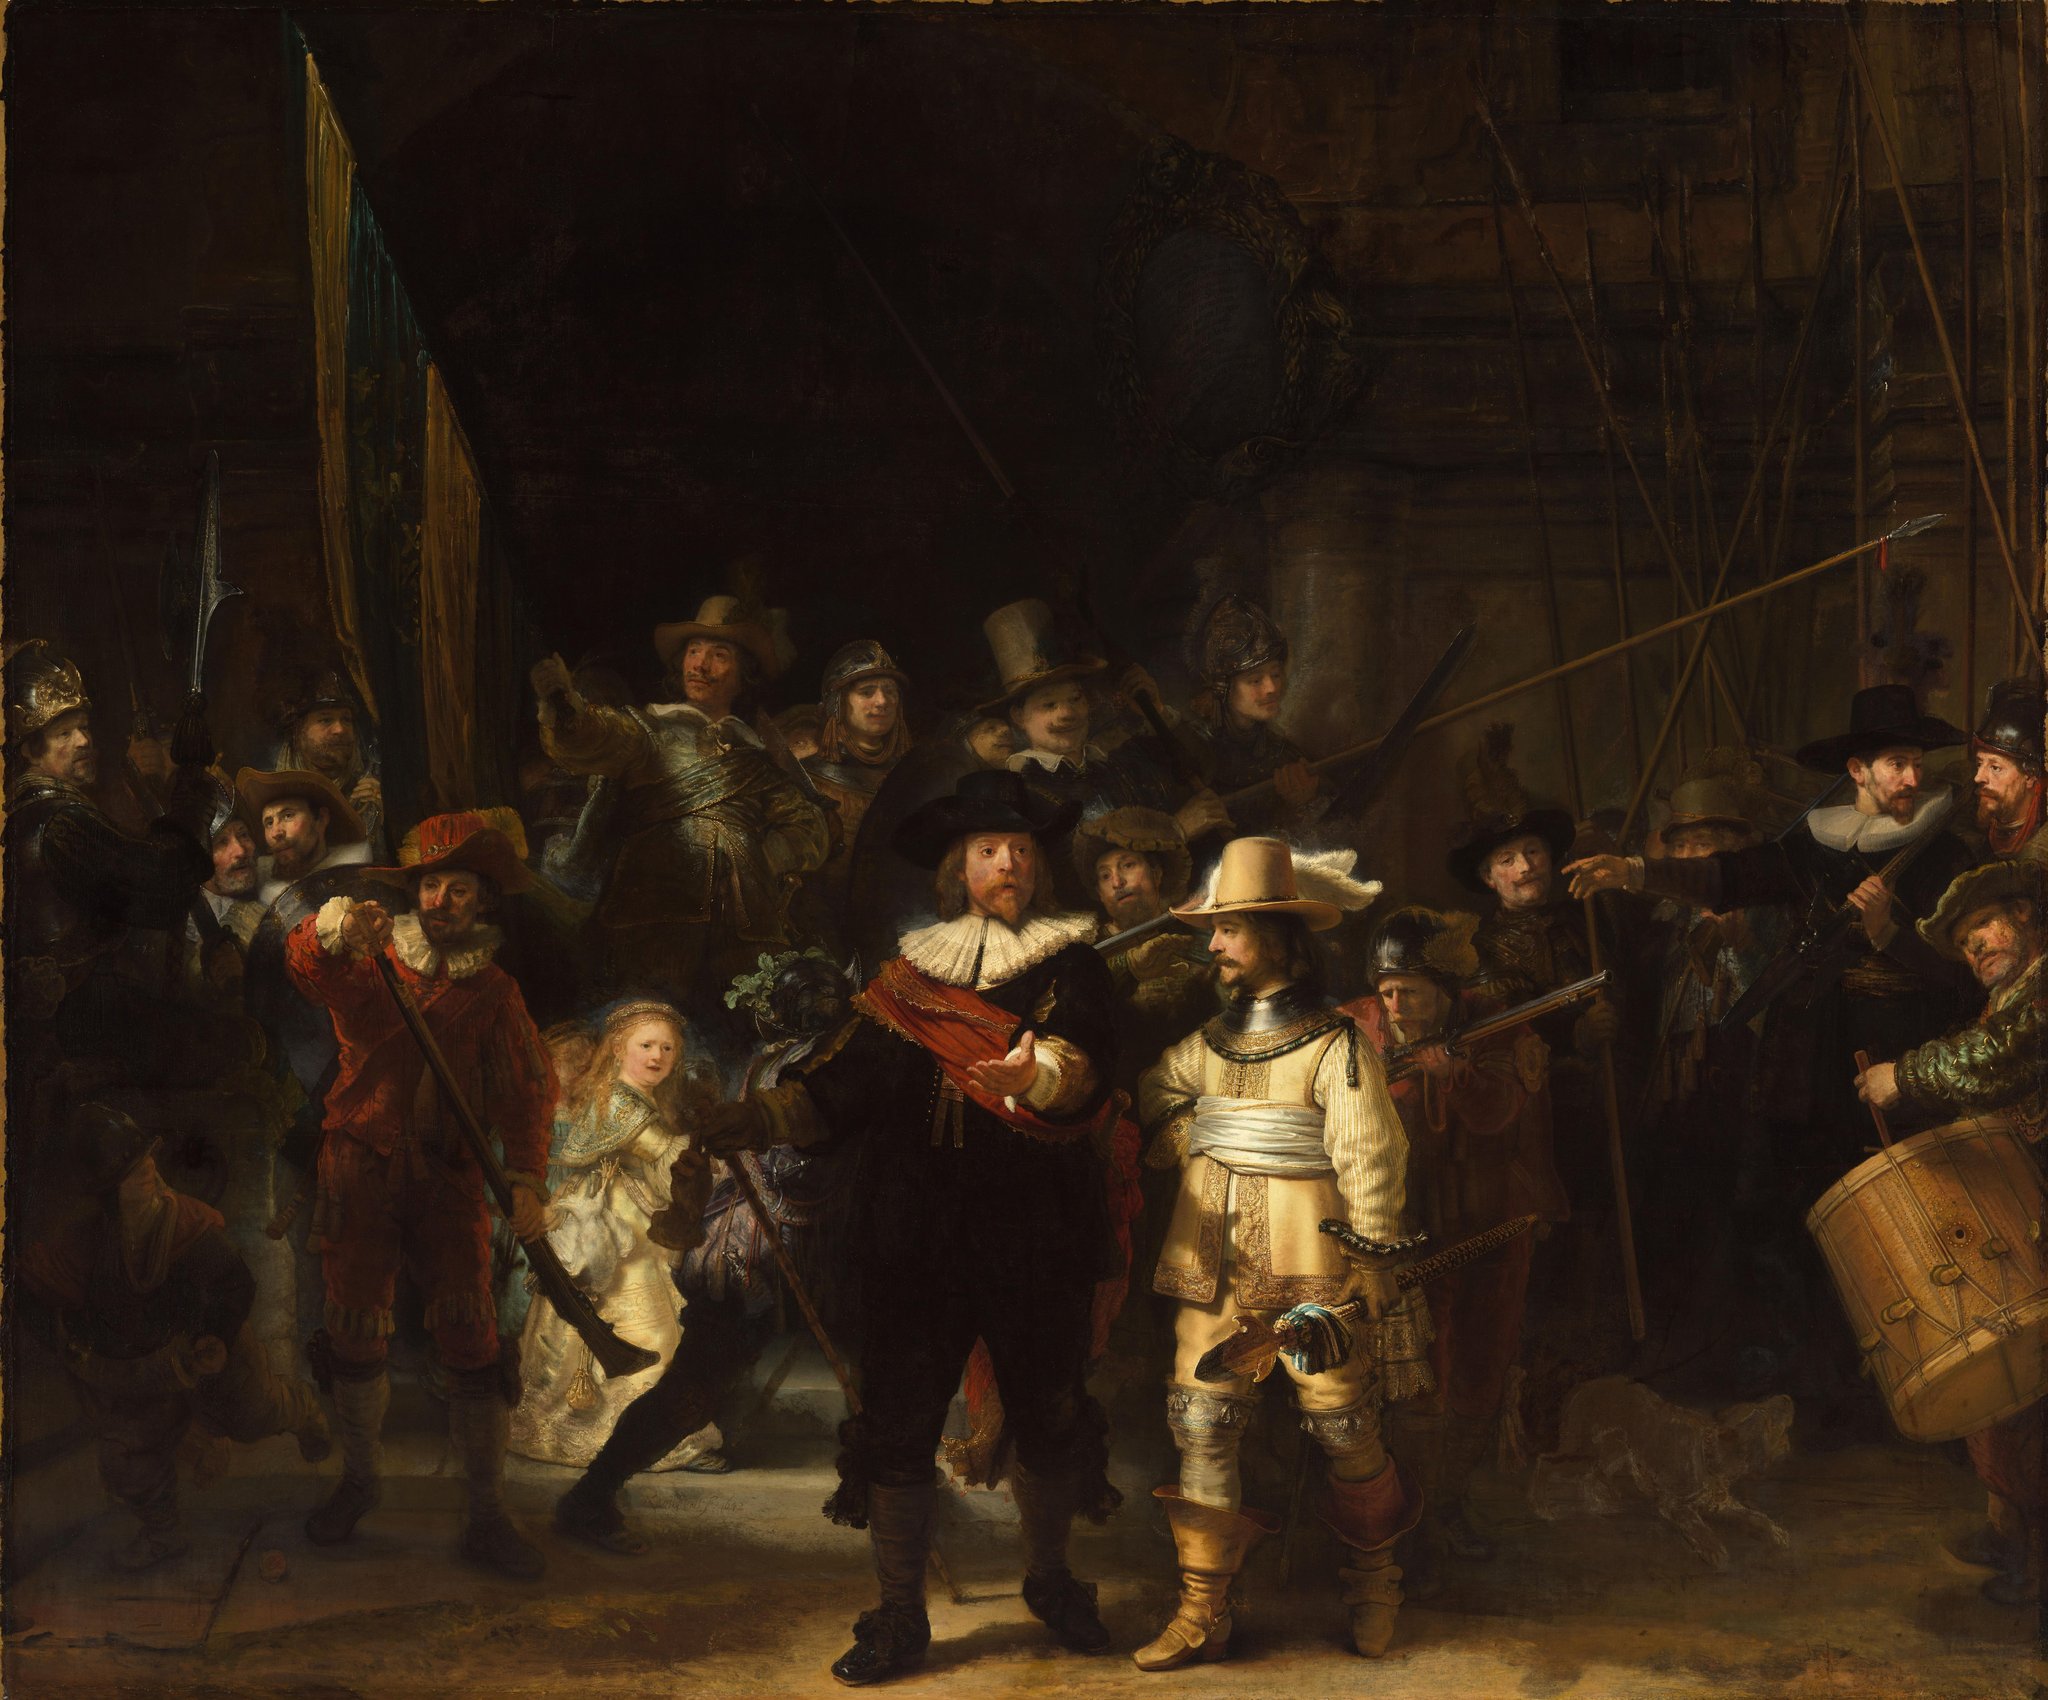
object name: painting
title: The Night Watch Militia Company of District II under the Command of Captain Frans Banninck Cocq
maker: rembrandt van rijn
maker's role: draughtsman, painter, print maker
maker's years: 1606-1669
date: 1642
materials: canvas, oil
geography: amsterdam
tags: frans banninck cocq, maarssen, (military) standard-bearer, girl (child between toddler and youth), drum (musical instrument), weapons, warfare; military affairs (+ citizen soldiery, civil guard, citizen militia), dog, amsterdam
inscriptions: signature and date: ‘Rembrandt f 1642’, inscription: ‘Frans Banning Cocq, heer van purmerlant en Ilpendam, Capiteijn Willem van Ruijtenburch van Vlaerdingen, heer van Vlaerdingen, Lu[ij]tenant, Jan Visscher Cornelisen Vaendrich, Rombout Kemp Sergeant, Reijnier Engelen Sergeant, Barent Harmansen, Jan Adriaensen Keyser, Elbert Willemsen, Jan Clasen Leydeckers, Jan Ockersen, Jan Pietersen bronchorst, Harman Iacobsen wormskerck, Jacob Dircksen de Roy, Jan vander heede, Walich Schellingwou, Jan brugman, Claes van Cruysbergen, Paulus Schoonhoven’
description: Rembrandt’s largest, most famous canvas was made for the Arquebusiers guild hall. This was one of several halls of Amsterdam’s civic guard, the city’s militia and police. Rembrandt was the first to paint figures in a group portrait actually doing something. The captain, dressed in black, is telling his lieutenant to start the company marching. The guardsmen are getting into formation. Rembrandt used the light to focus on particular details, like the captain’s gesturing hand and the young girl in the background. She was the company mascot.